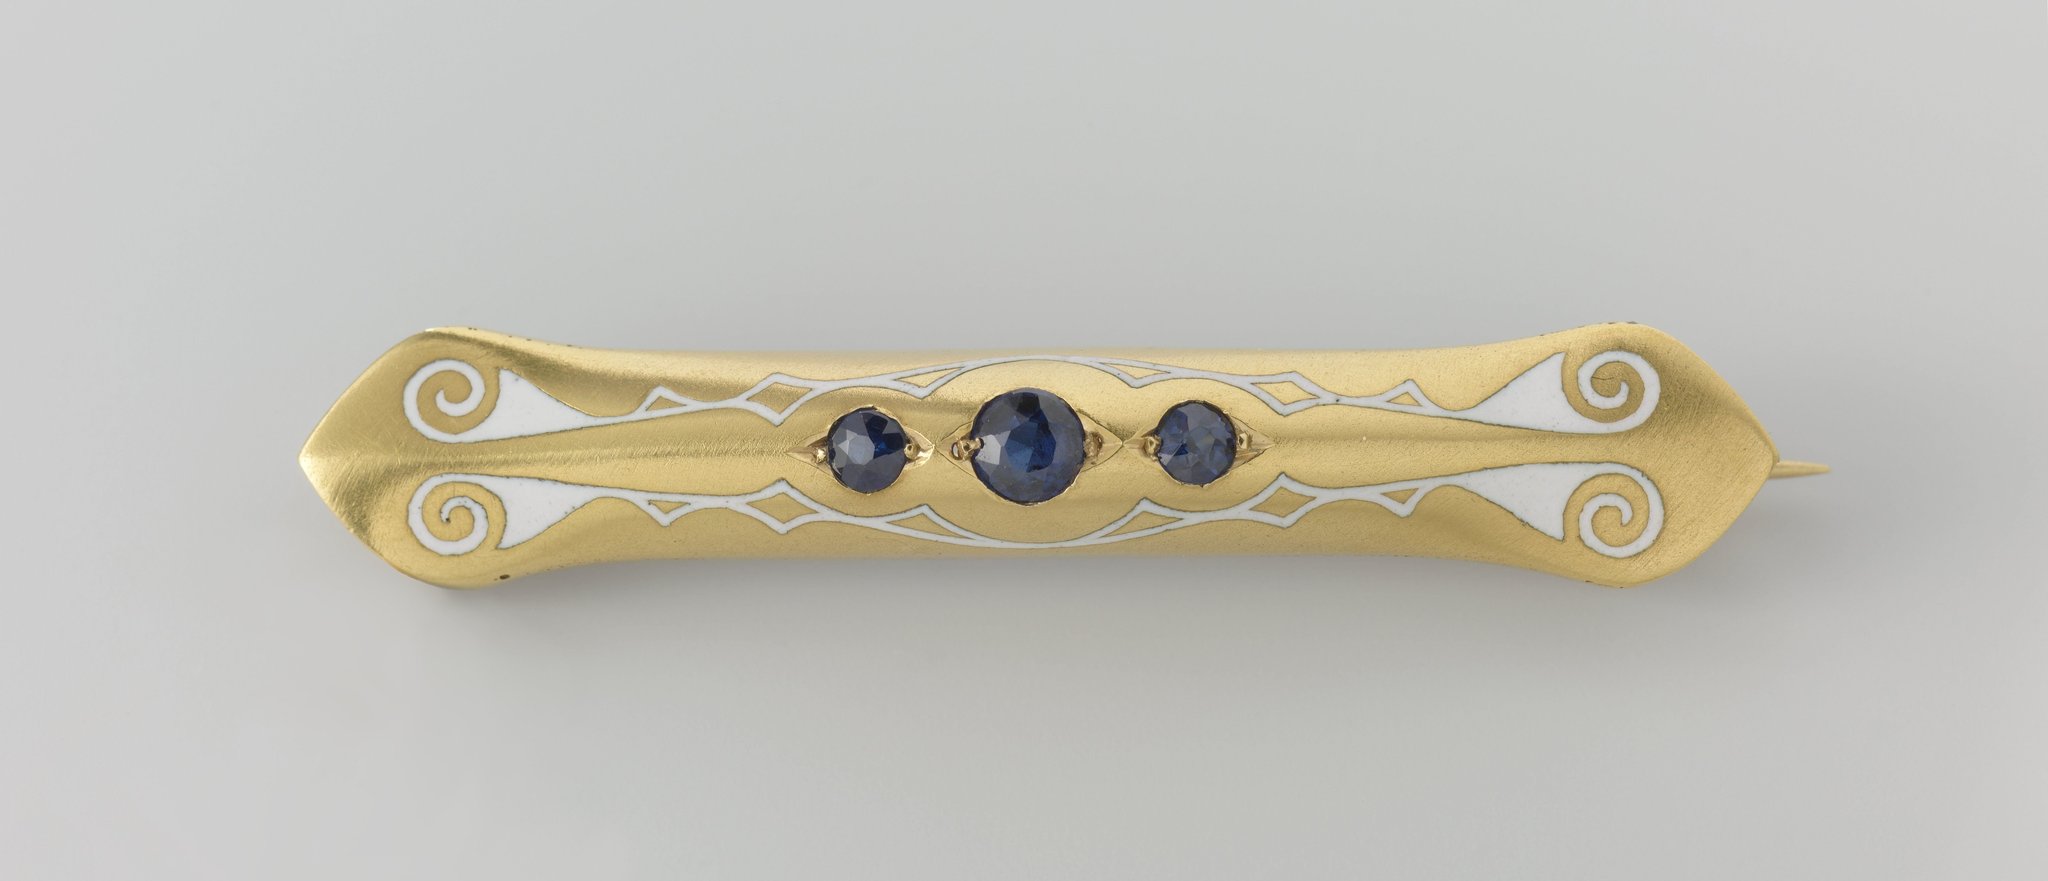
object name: brooch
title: Broche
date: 1908-1911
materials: gold, gemstone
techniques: enameling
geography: amsterdam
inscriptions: alloy mark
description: Jewellery. Gold, silver, enamel and semi-precious stones. Amsterdam, c. 1908 - 1911, by L.W. van Kooten, designed by Bert Nienhuis. Given by the Prins Bernhard Fonds, 1980.